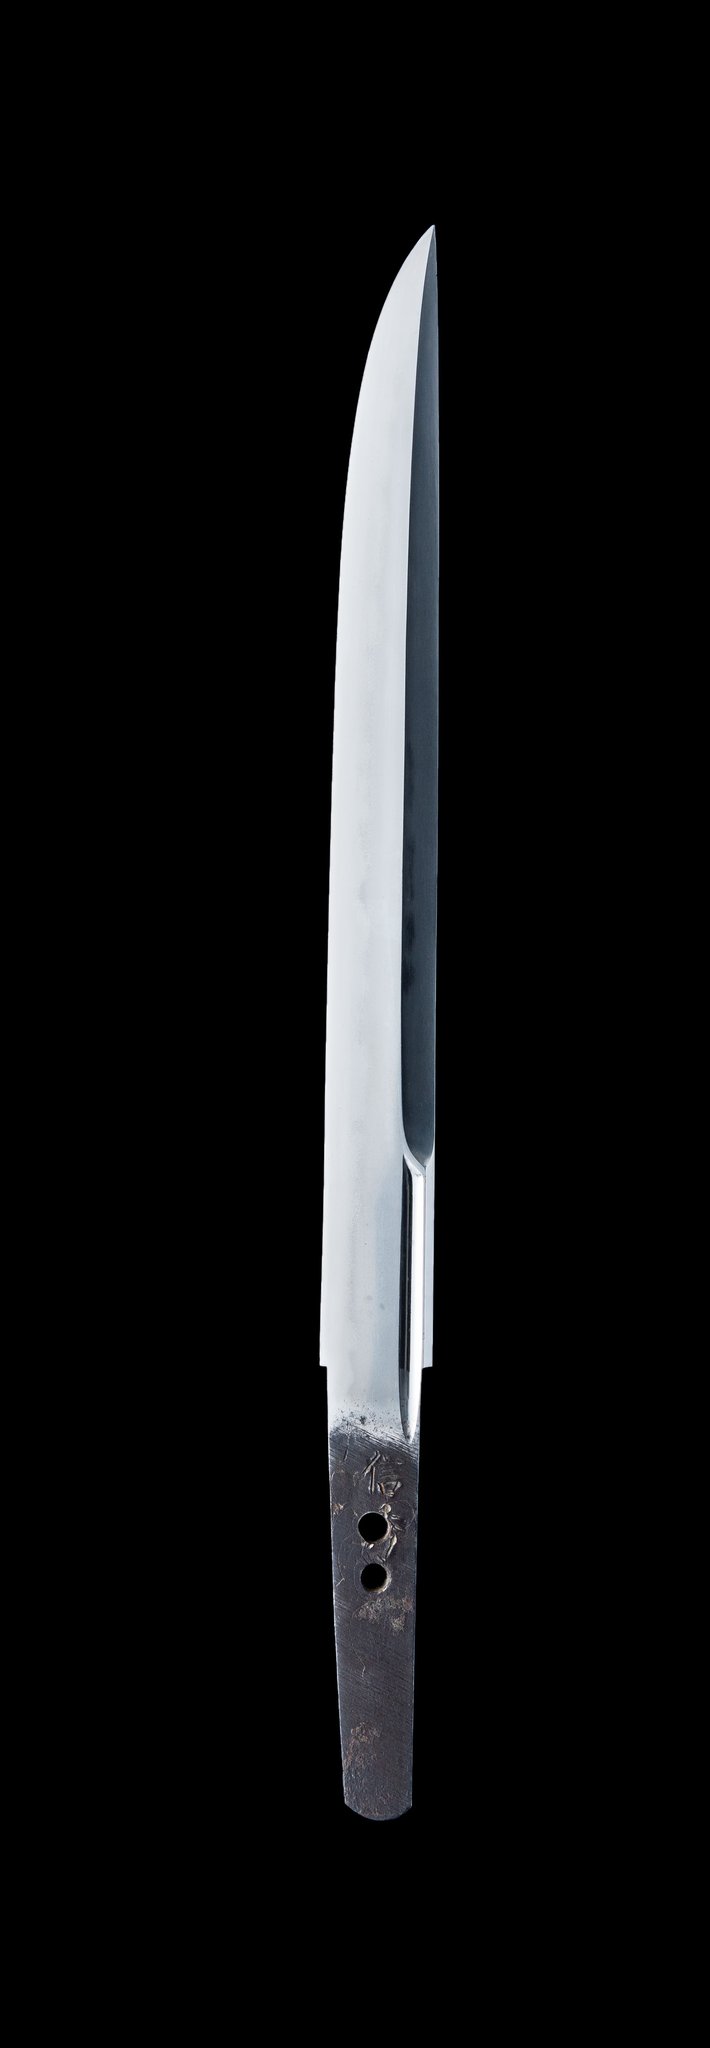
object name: blade and mounting for a dagger tantō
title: Blade and Mounting for a Dagger (Tantō)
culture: japanese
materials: gold, lacquer, silver, steel, wood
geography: japan